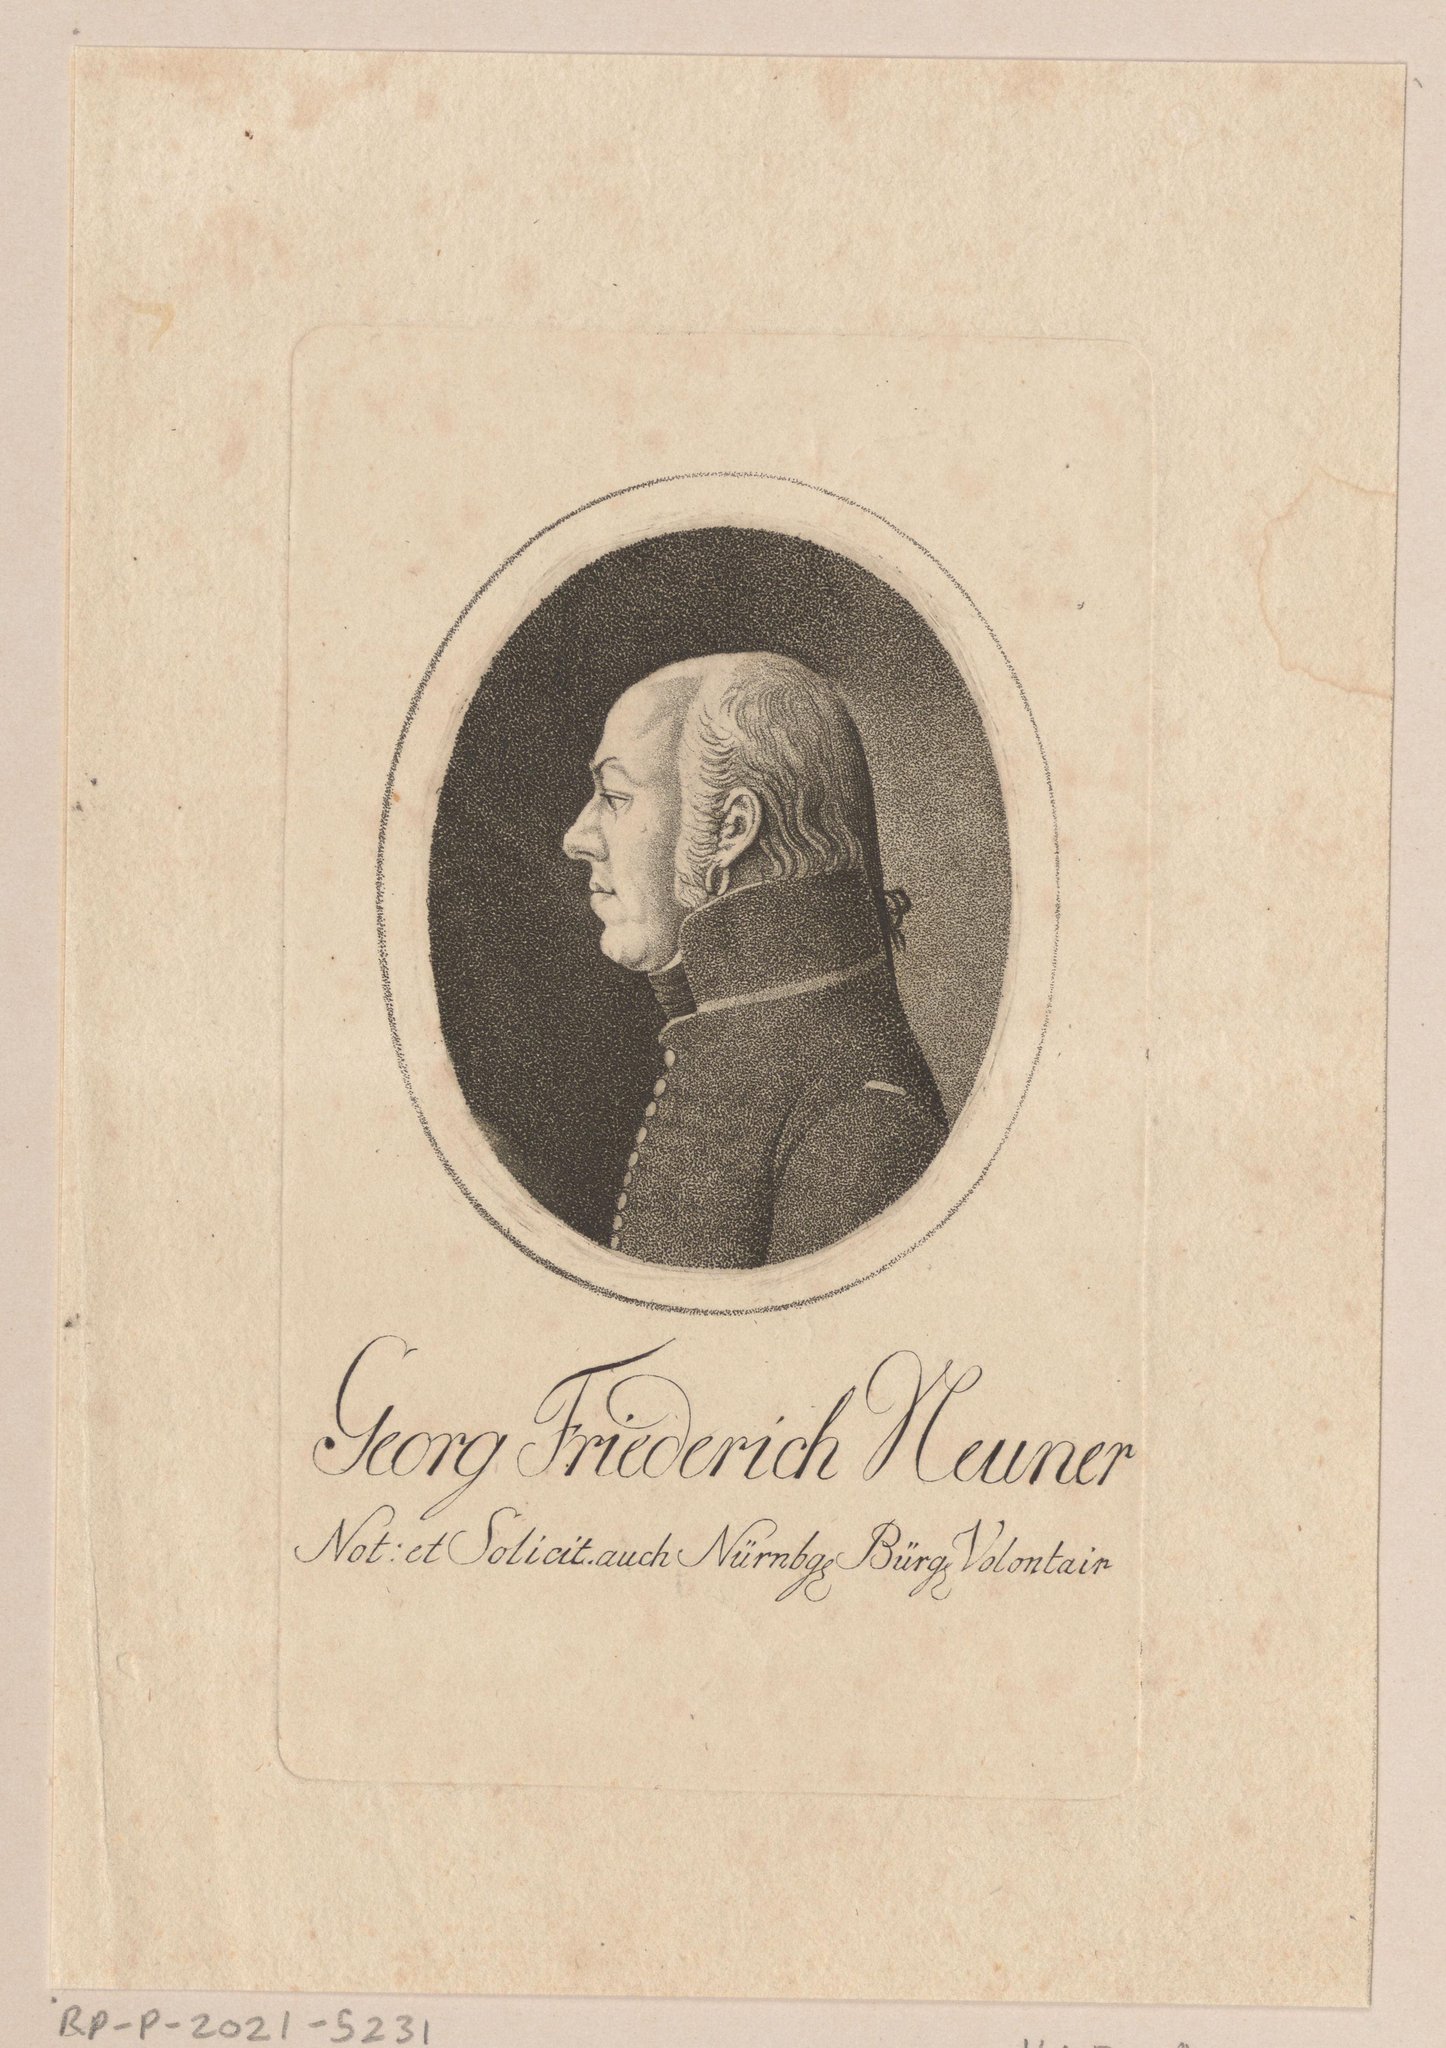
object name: print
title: Portret van Georg Friedrich Neuner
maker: johann christian wilhelm adelmann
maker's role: print maker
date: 1780-1820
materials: paper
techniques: engraving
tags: historical persons, law and jurisprudence